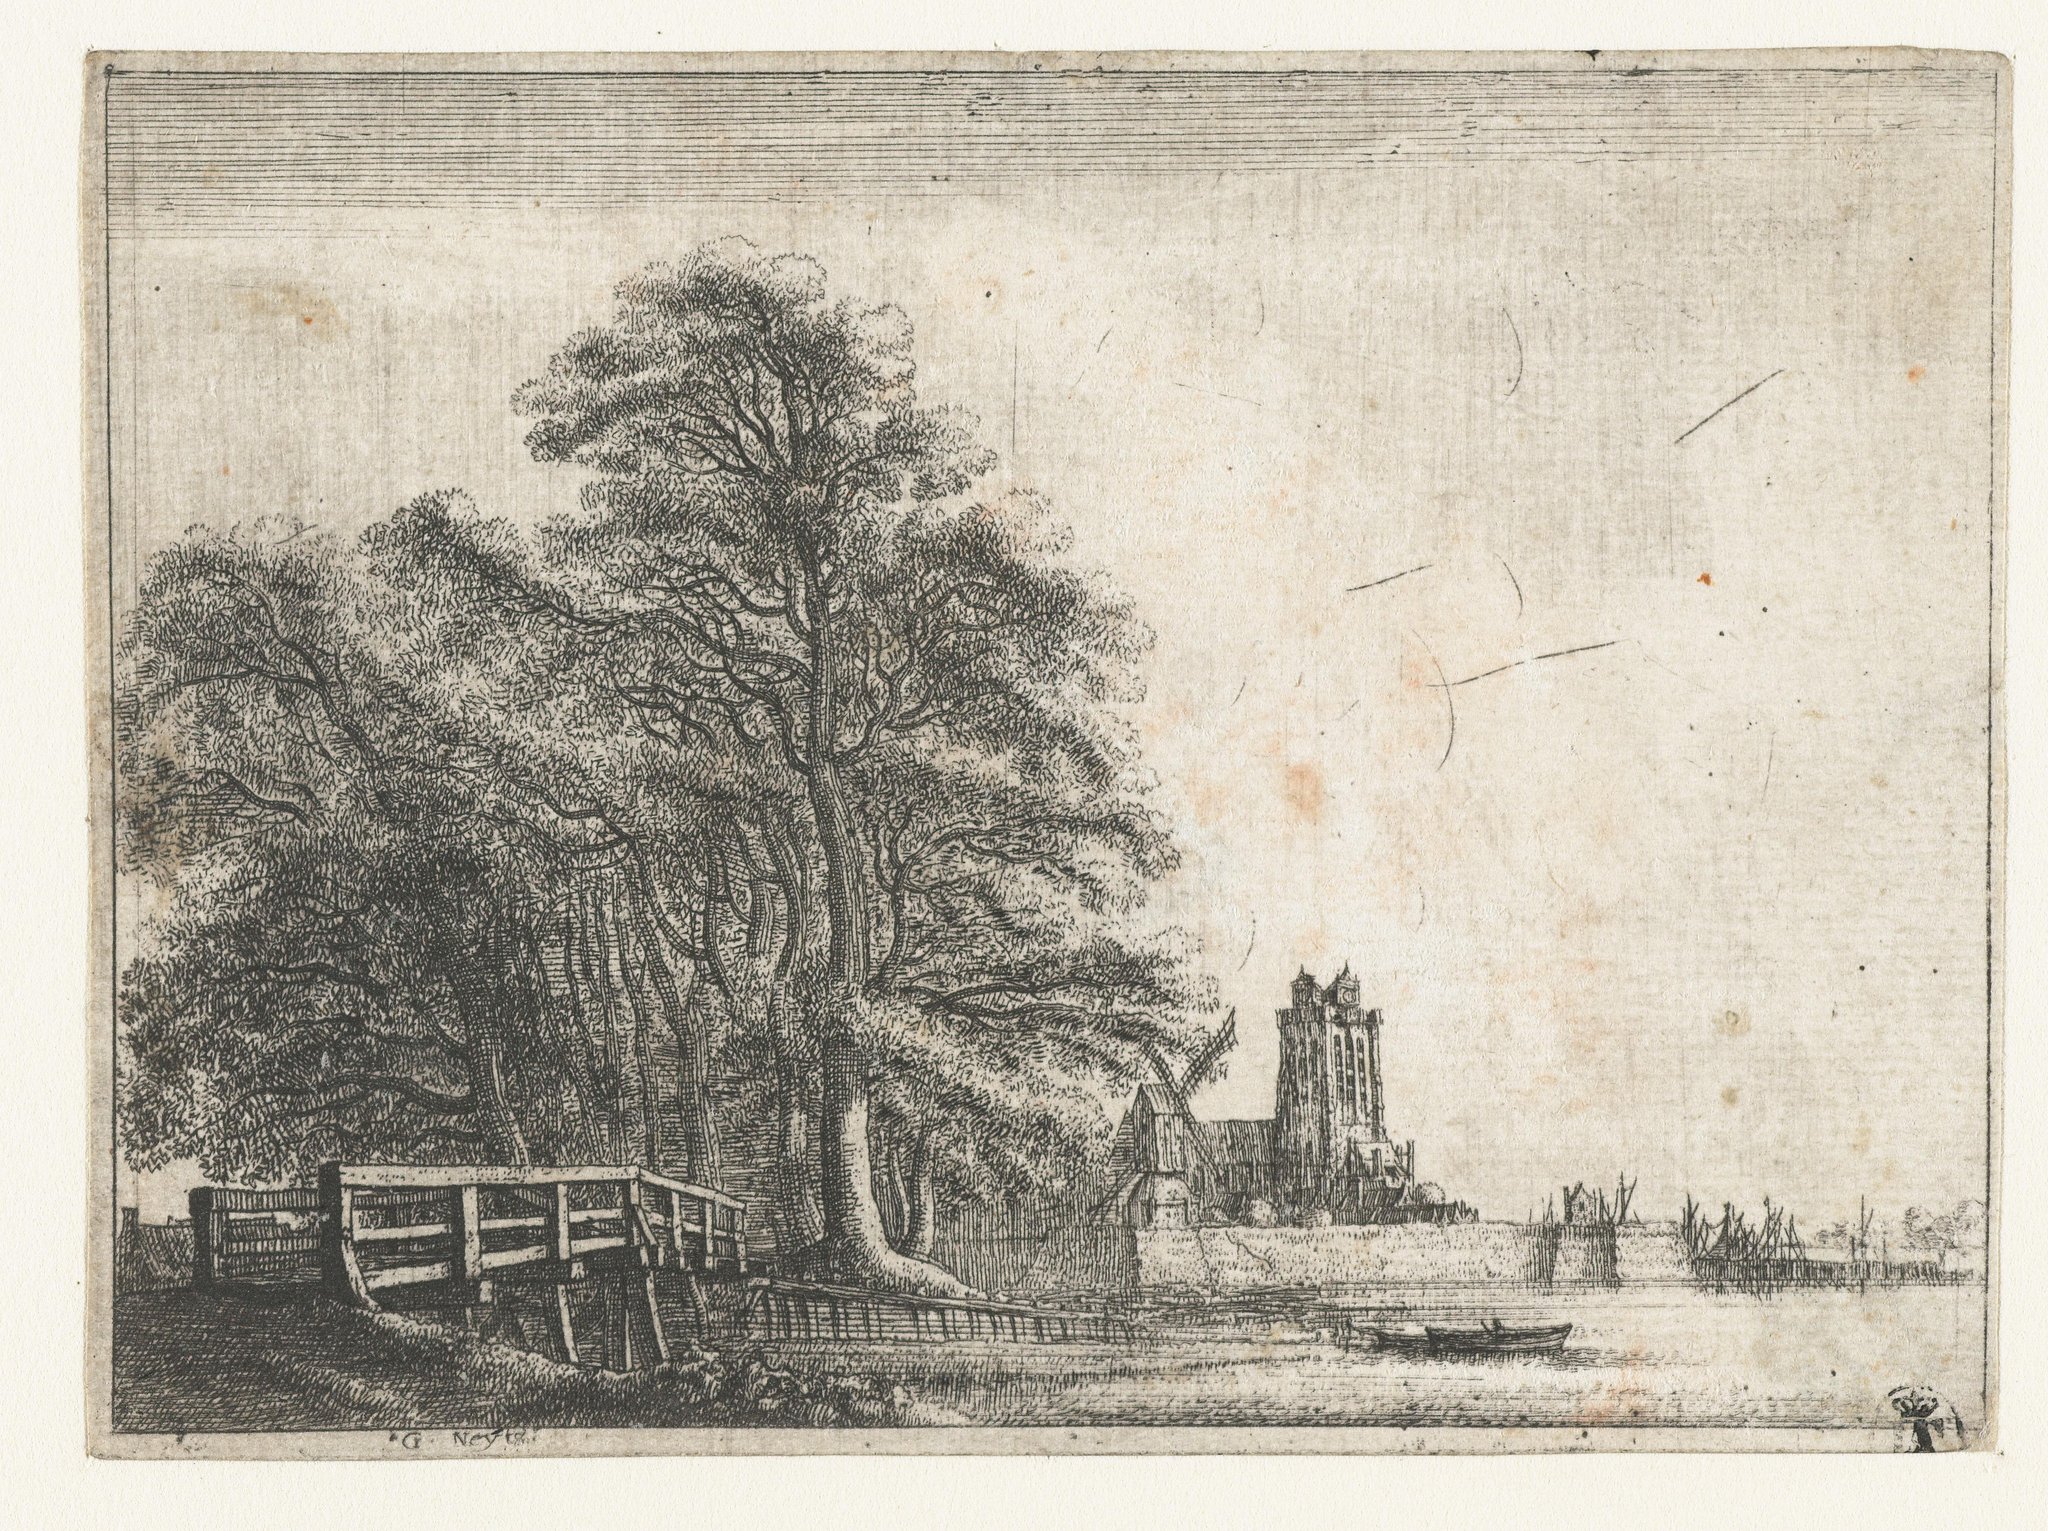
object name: print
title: Landschap met gezicht op Dordrecht rechts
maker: gilles neyts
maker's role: draughtsman, print maker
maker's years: 1623-1687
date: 1643-1681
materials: paper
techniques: etching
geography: antwerp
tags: landscapes in the temperate zone, prospect of city, town panorama, silhouette of city, dordrecht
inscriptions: collector's mark: Lugt 2710, collector's mark: Lugt 2228a, collector's mark: Lugt 971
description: Landschap met bomen. Links op de voorgrond een bruggetje, rechts op de achtergrond een deel van de stadsmuur van Dordrecht, met daar direct achter een molen en een kerk.